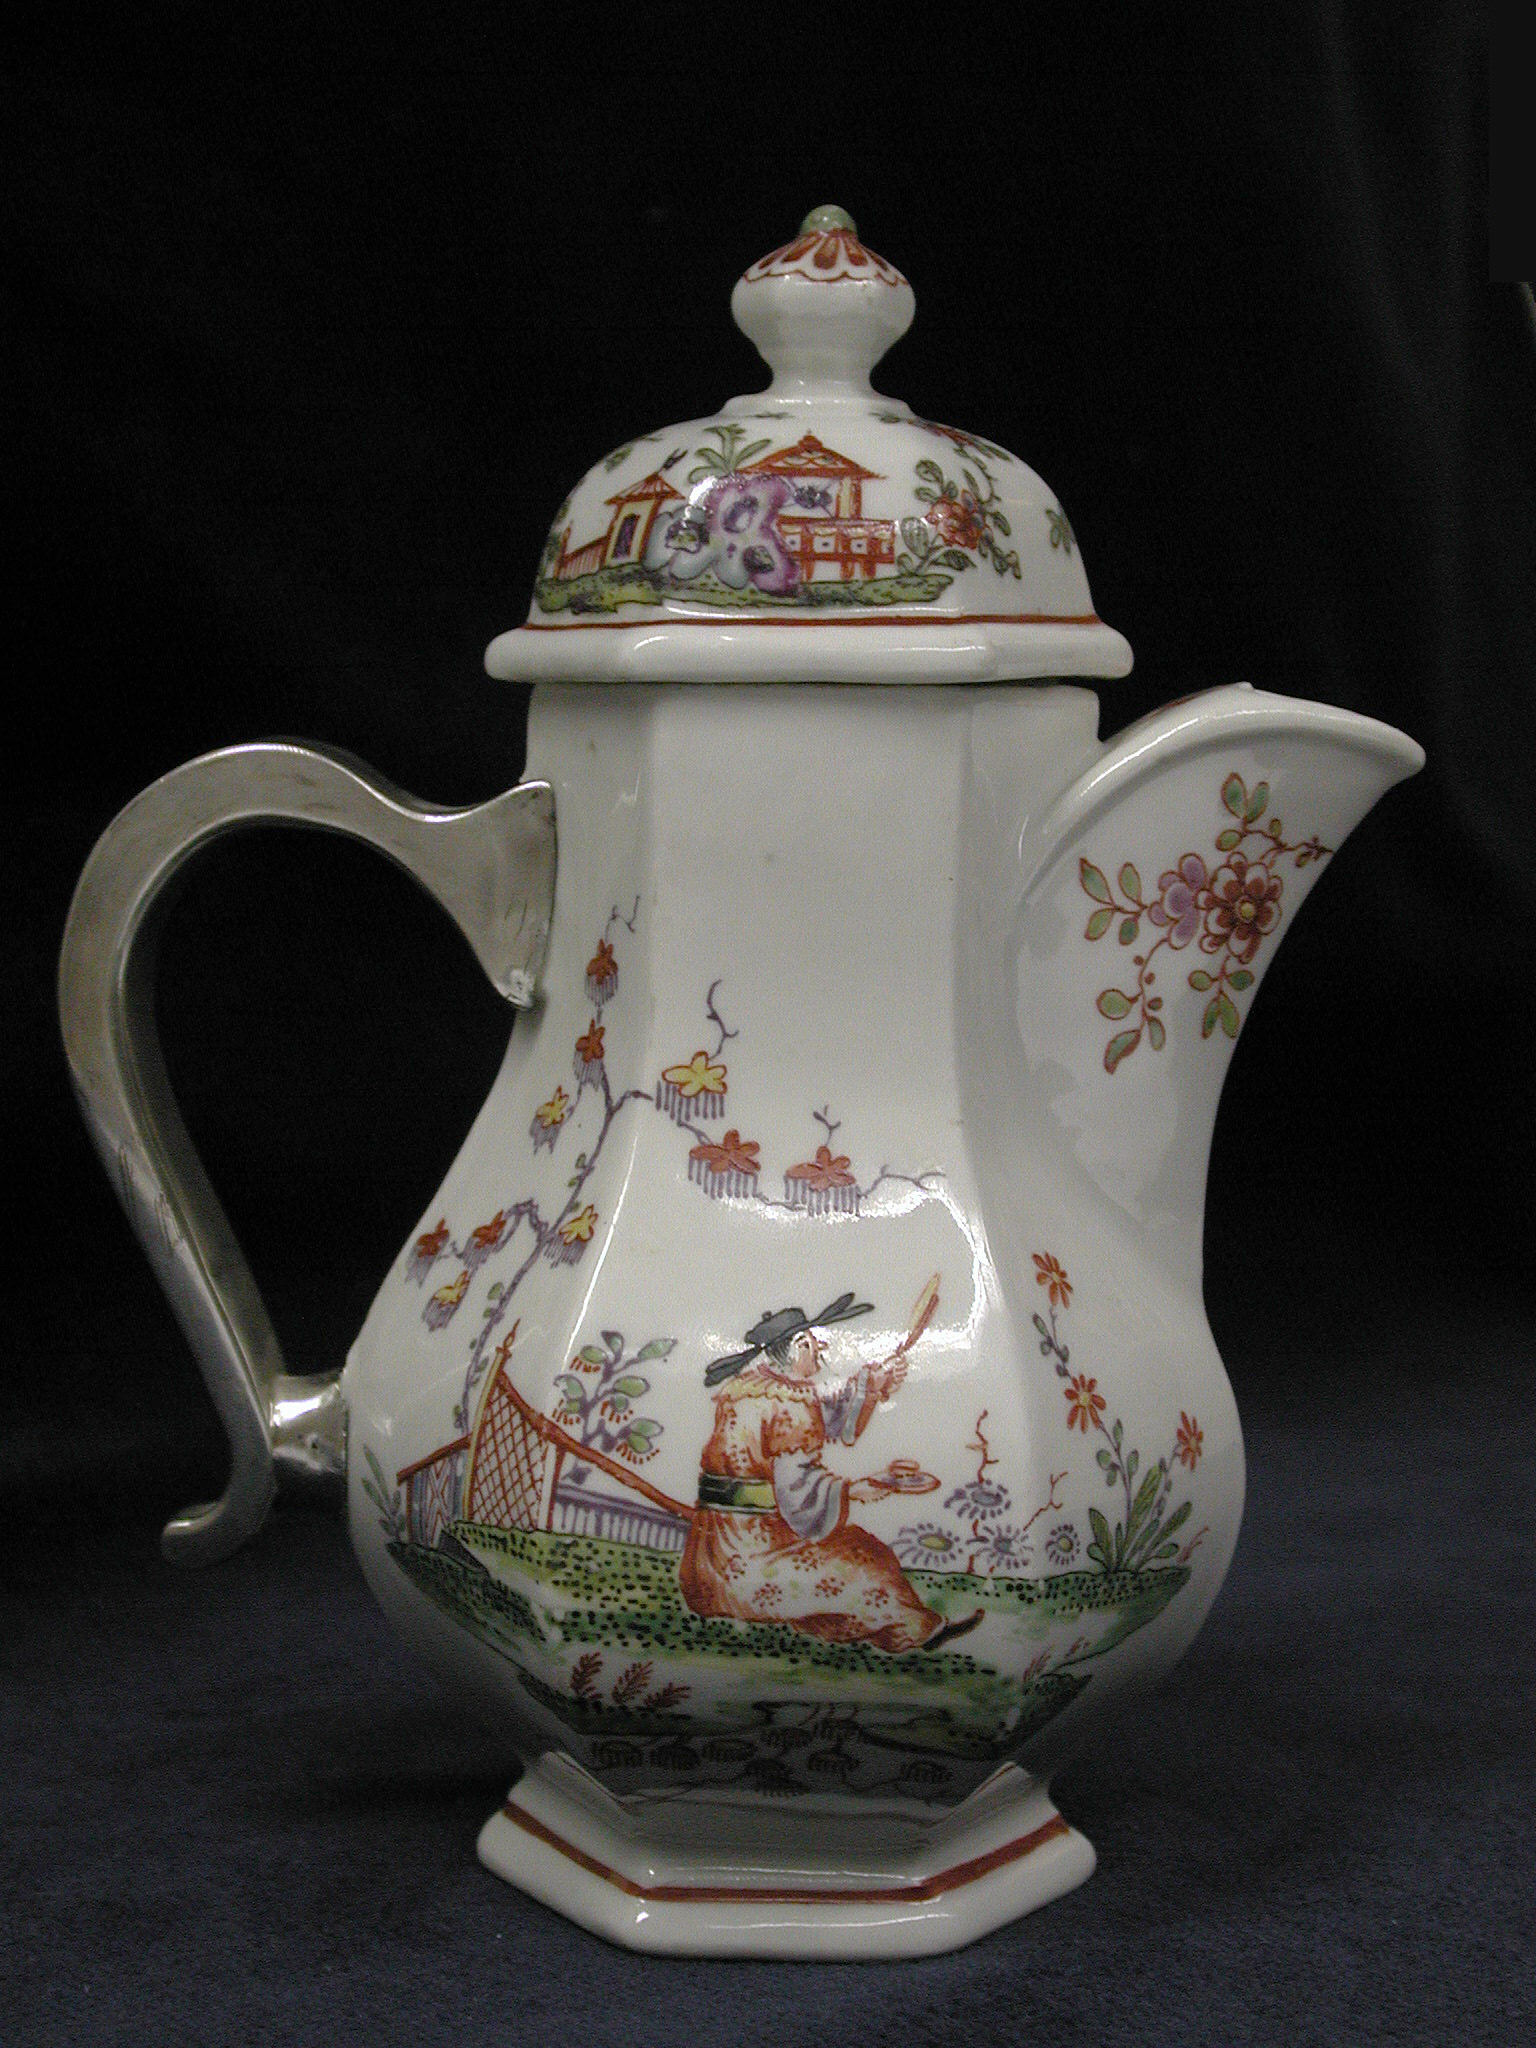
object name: coffeepot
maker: vienna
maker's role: manufactory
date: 1725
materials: hard paste porcelain, silver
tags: houses,men,flowers